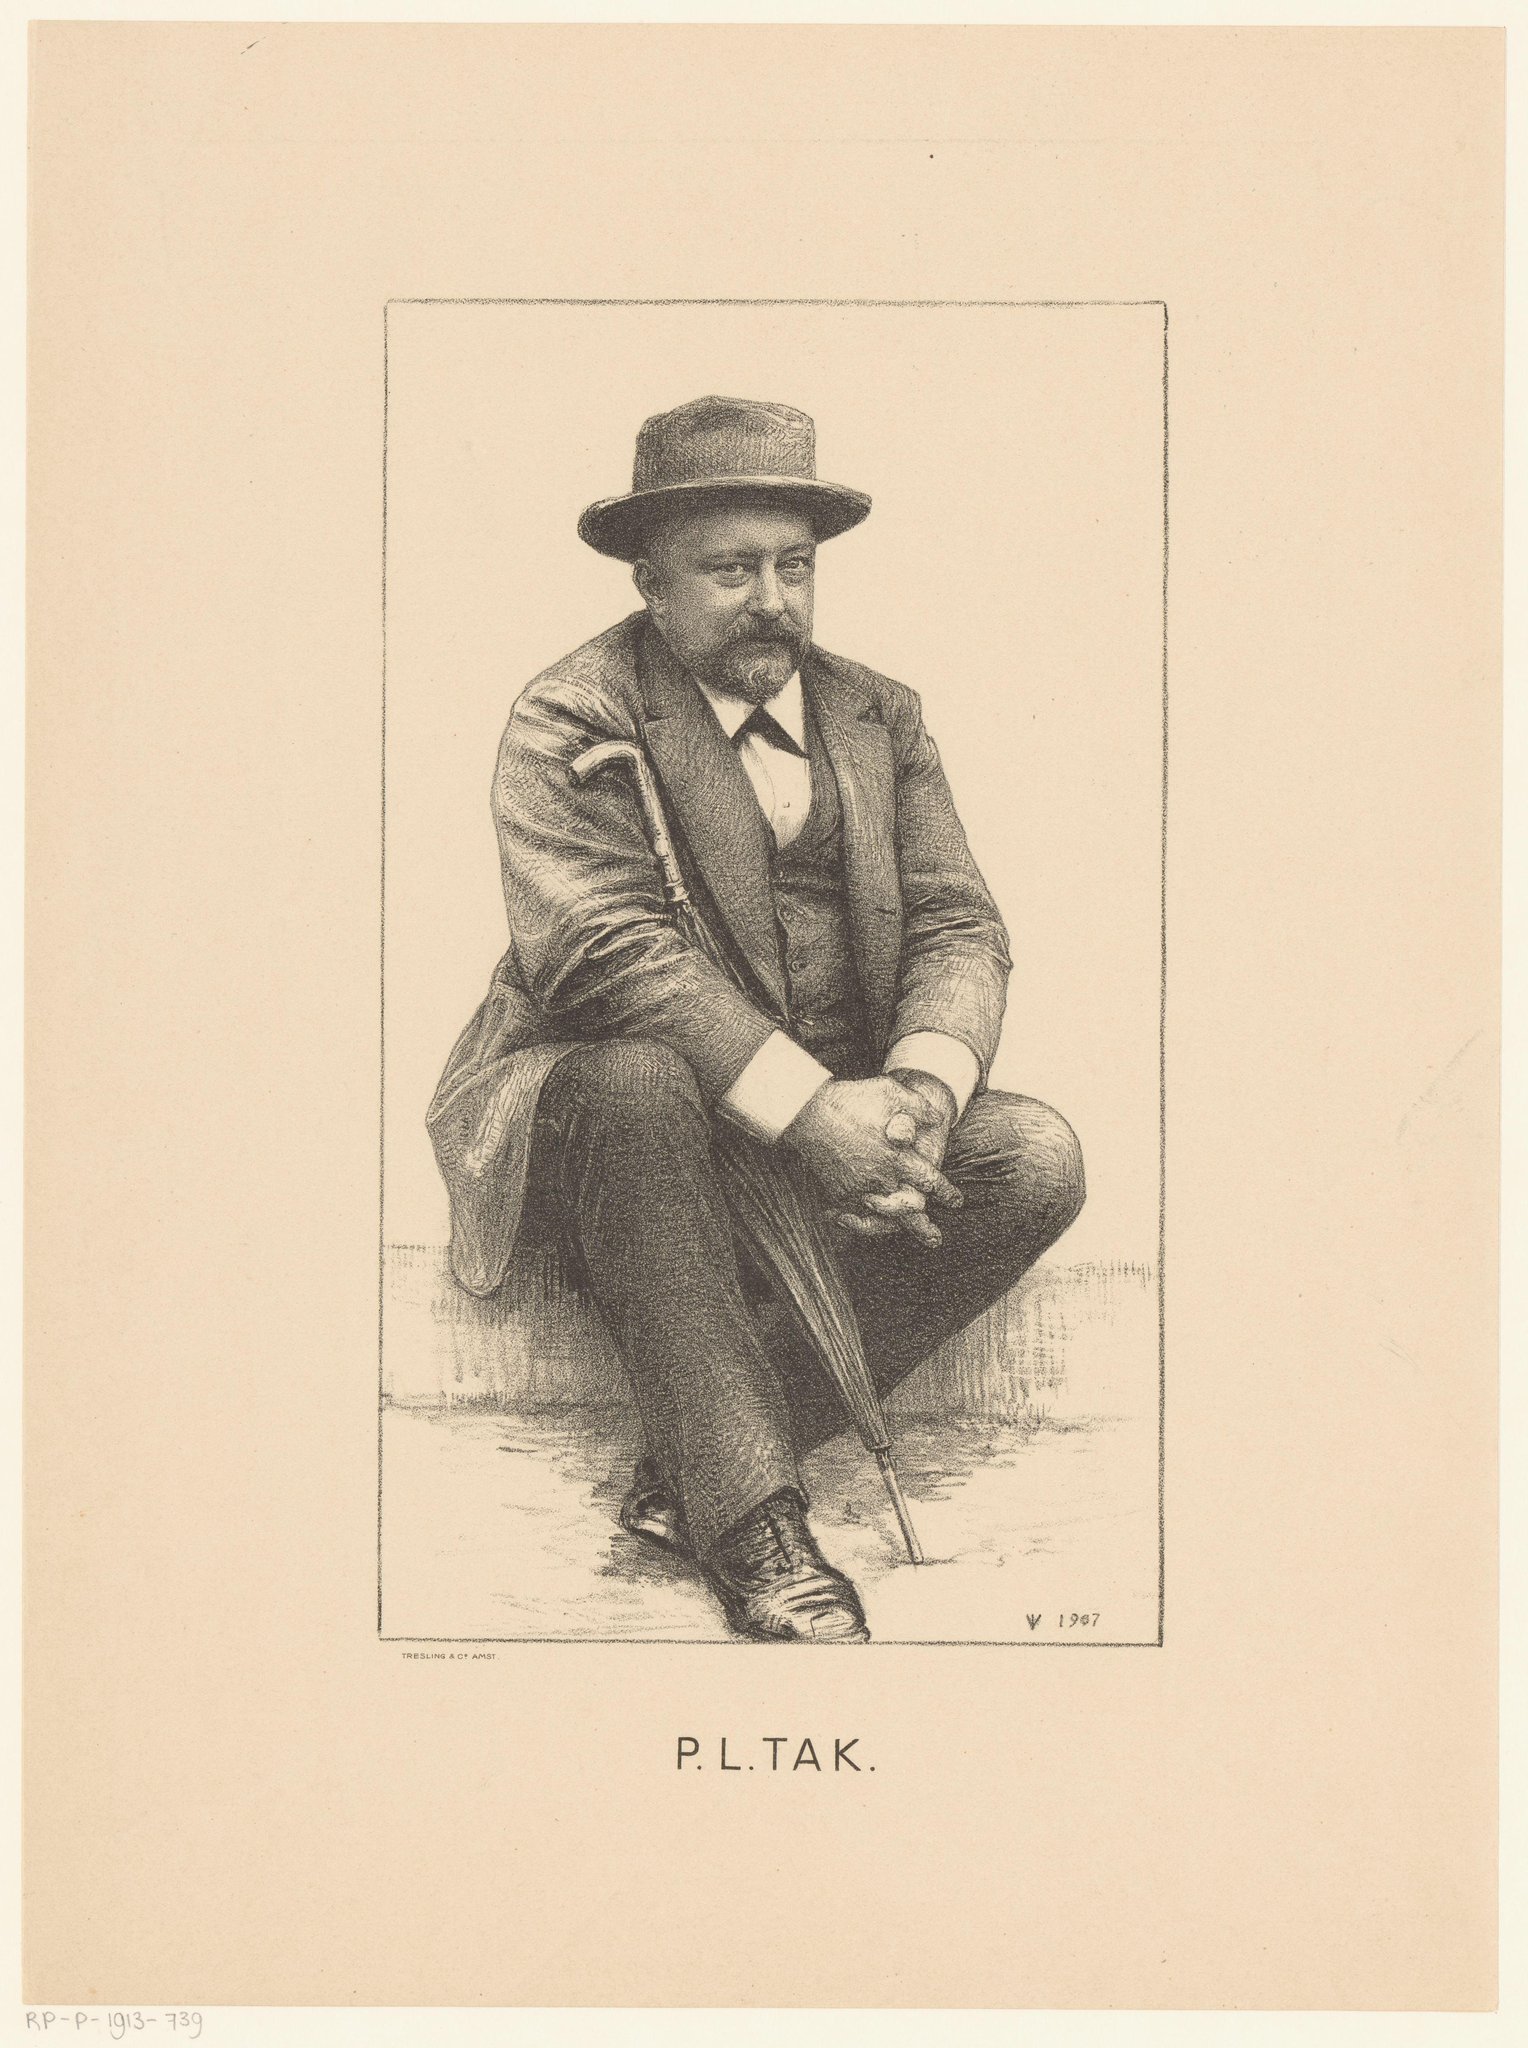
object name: print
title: Portret van Pieter Lodewijk Tak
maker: jan veth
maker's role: designer, draughtsman, painter, print maker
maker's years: 1864-1925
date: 1907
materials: paper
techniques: lithograph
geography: amsterdam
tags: middelburg, politician, pieter lodewijk tak, historical persons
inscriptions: collector's mark: Lugt 2233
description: De geportretteerde zit op een verhoging met een paraplu onder zijn arm geklemd.